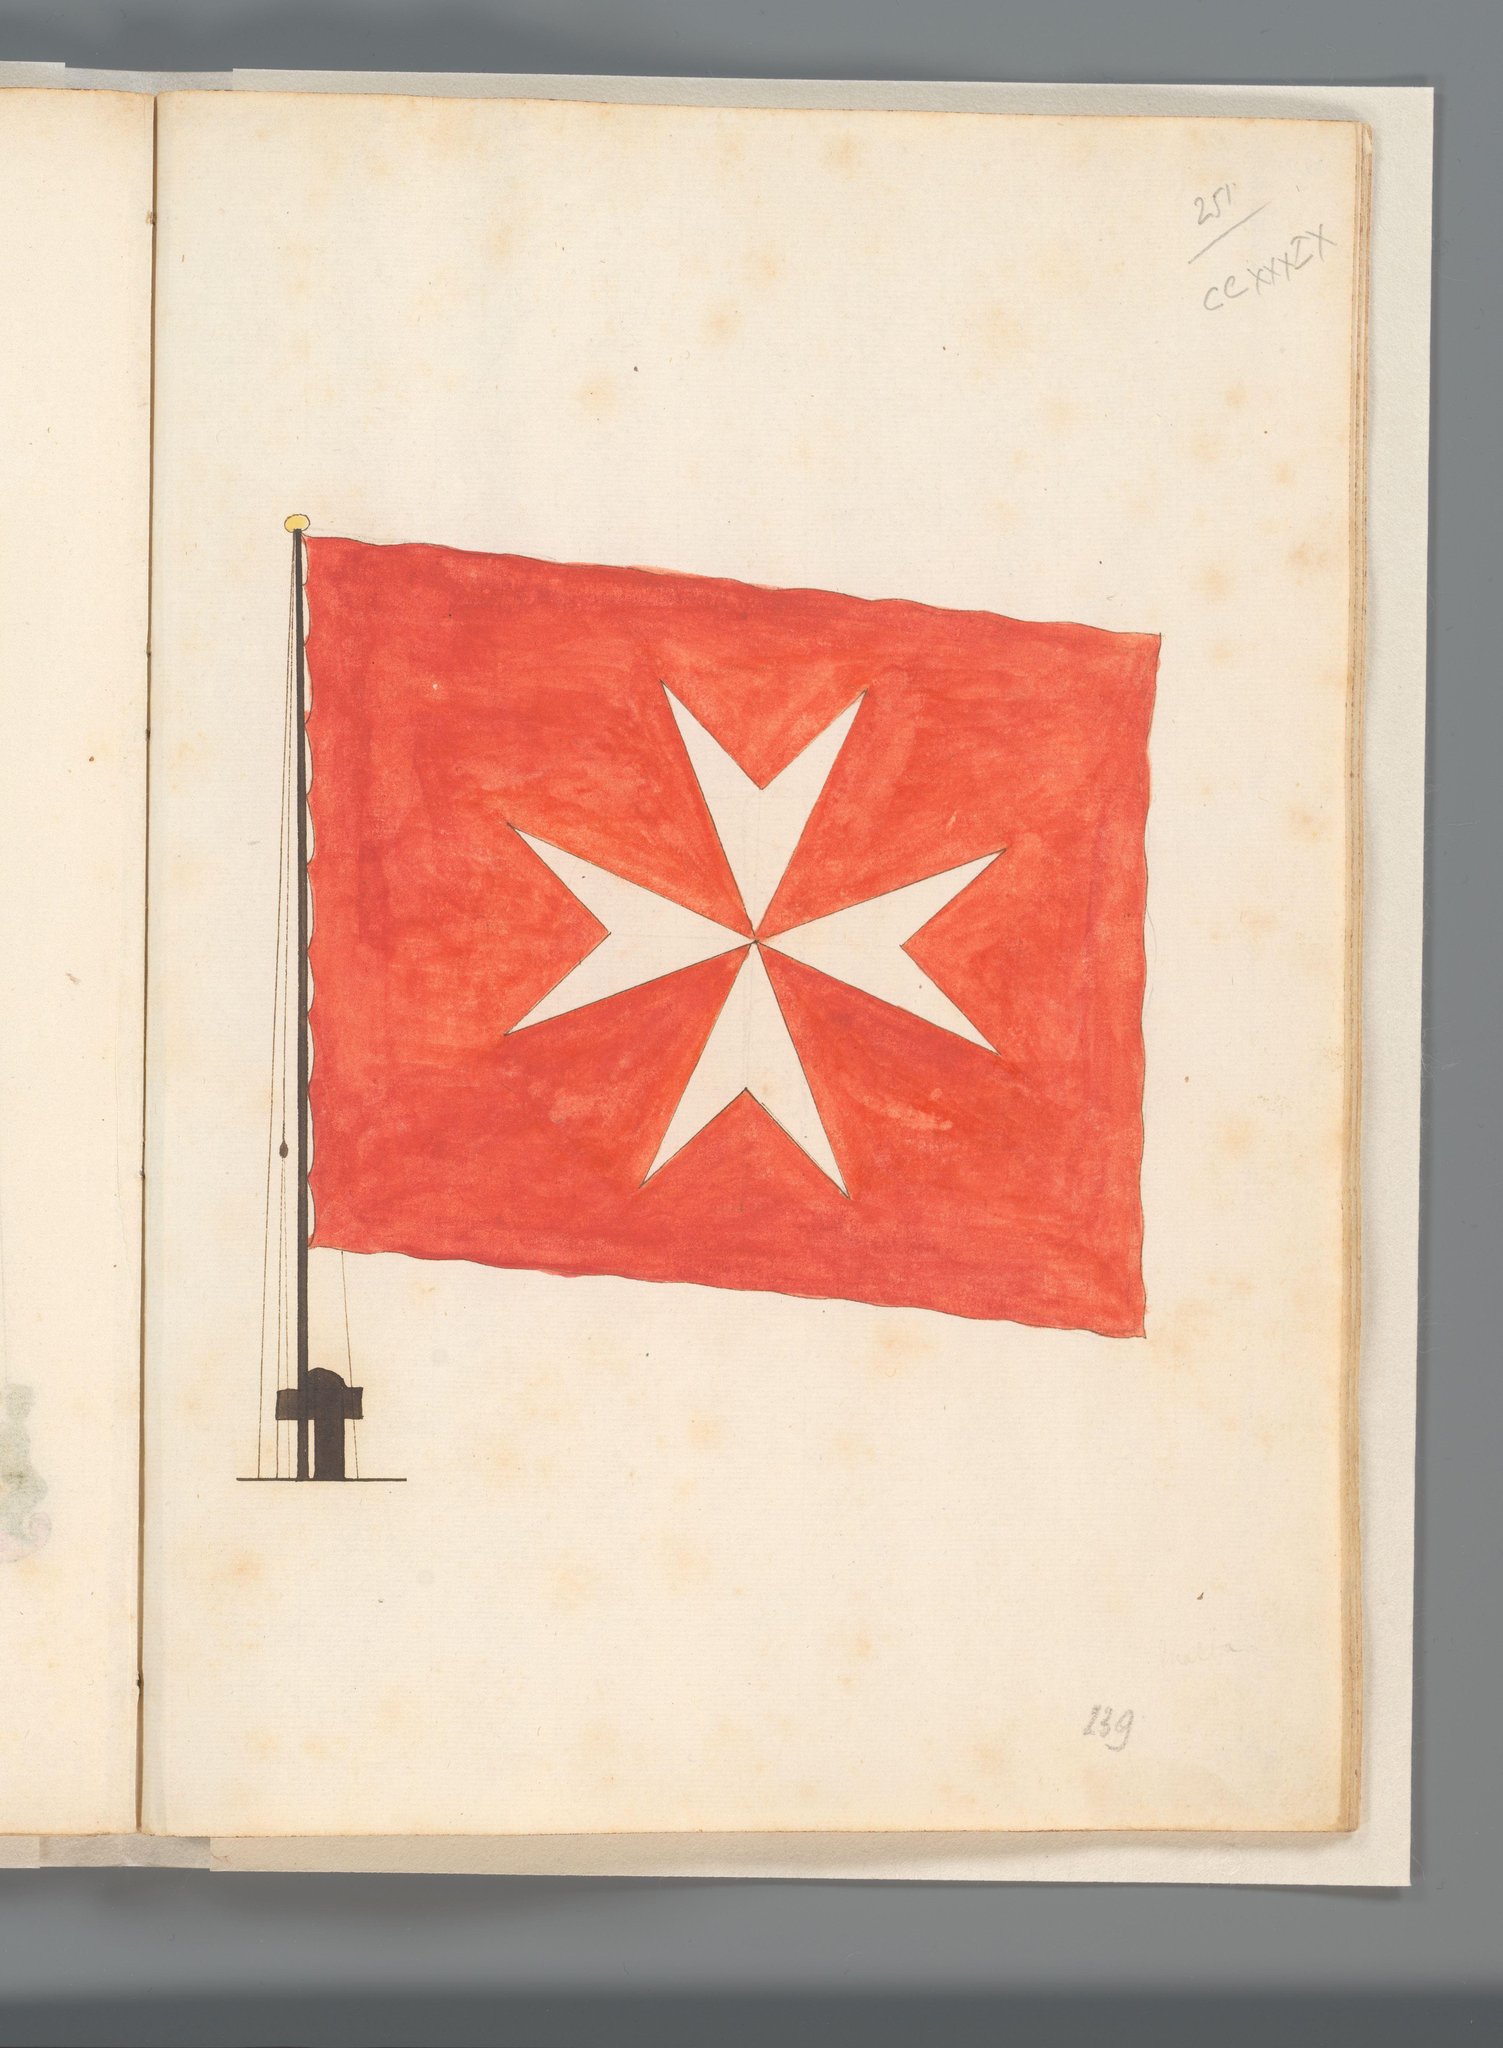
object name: drawing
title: Vlag van Malta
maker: Anonymous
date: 1667-1670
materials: ink, paper, watercolor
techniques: brush, pen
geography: france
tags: flag, colours (as symbol of the state, etc.)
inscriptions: number: ‘251 / CCXXXIX / 239’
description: Vlag van Malta. Rode vlag met centraal een wit Maltezer kruis. Vlag op vlaggensteng en mastvoet. Afgebeeld op folio 120r. Onderdeel van een vlaggenboek met vlaggen uit Europa, Noord-Afrika, Nabije en Verre Oosten.